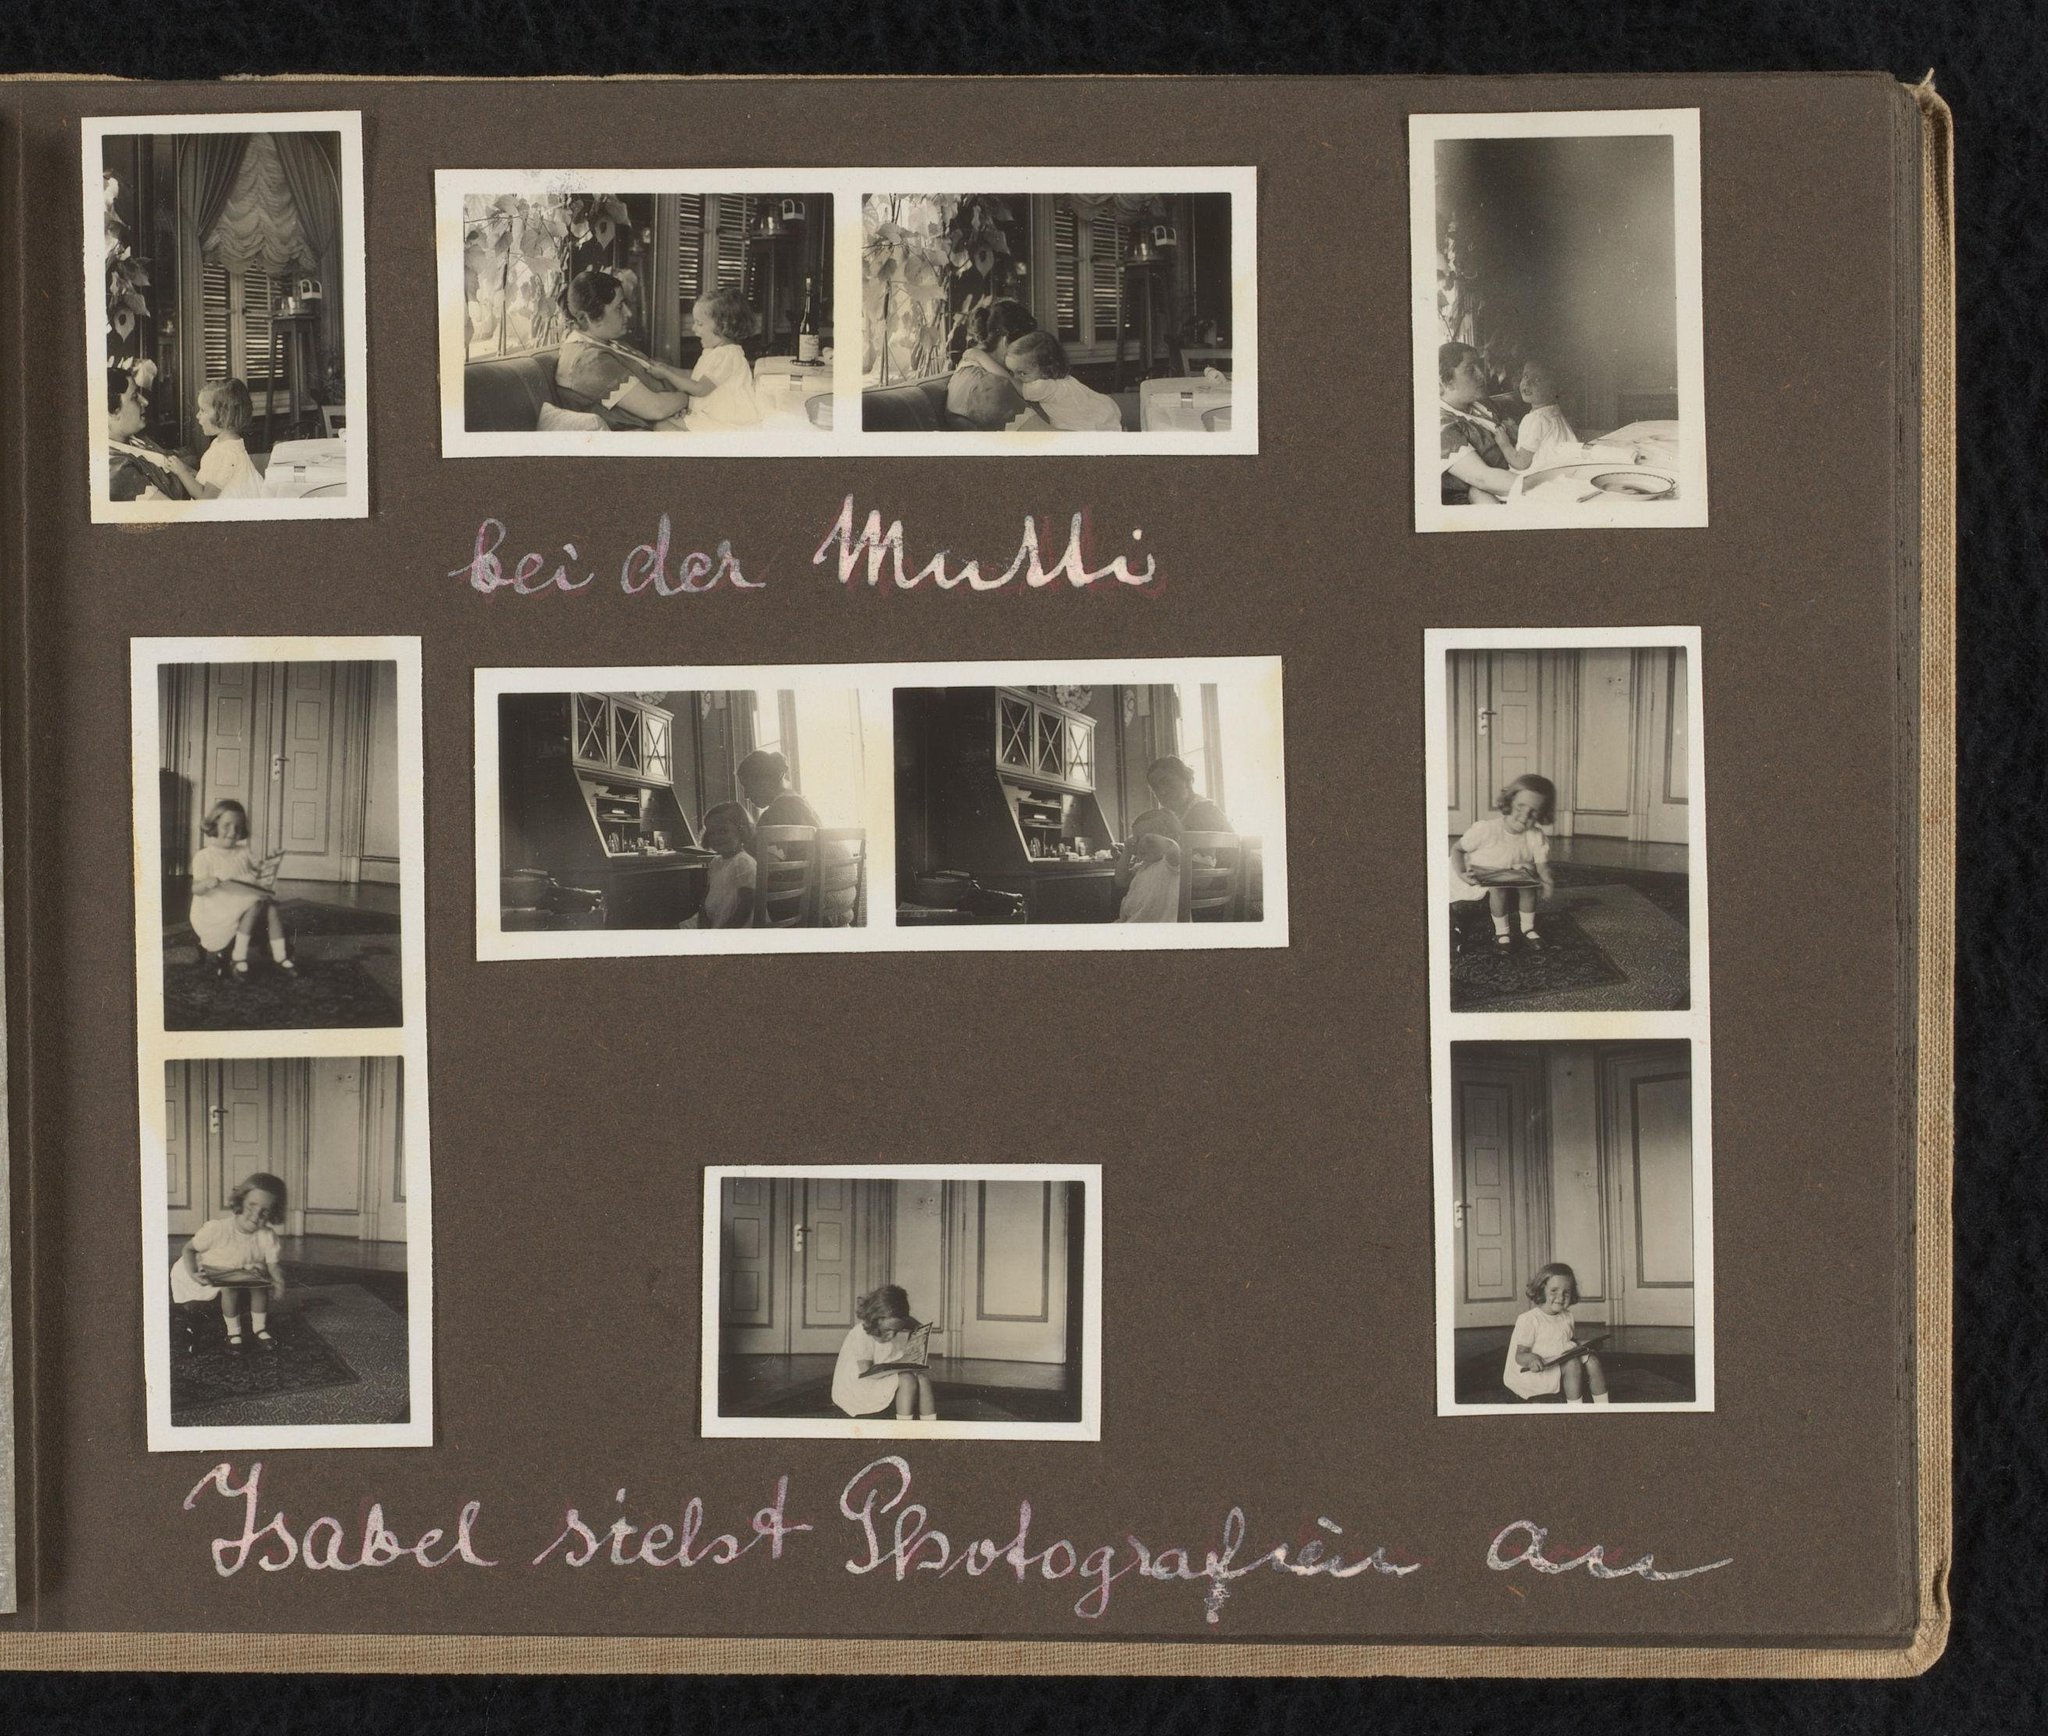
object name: album leaf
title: Isabel Wachenheimer bekijkt fotoalbum zit op schoot bij haar moeder Else Wachenheimer-Moos, juni 1931, München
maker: else wachenheimer-moos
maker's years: 1895-1944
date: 1906-1931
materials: cardboard, photographic support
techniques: gelatin silver print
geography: munich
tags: else wachenheimer-moos, leiden, isabel wachenheimer-elon, family life at home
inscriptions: inscription: ‘bei der Mutti Isabel stelst Photografien an’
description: Blad bevat tien foto's. Alle foto's van Isabel Wachenheimer (als klein meisje) en Else Wachenheimer-Moos. Uit het album, half formaat, crèmekleurig stofomslag met koordbinding met banenmotief.